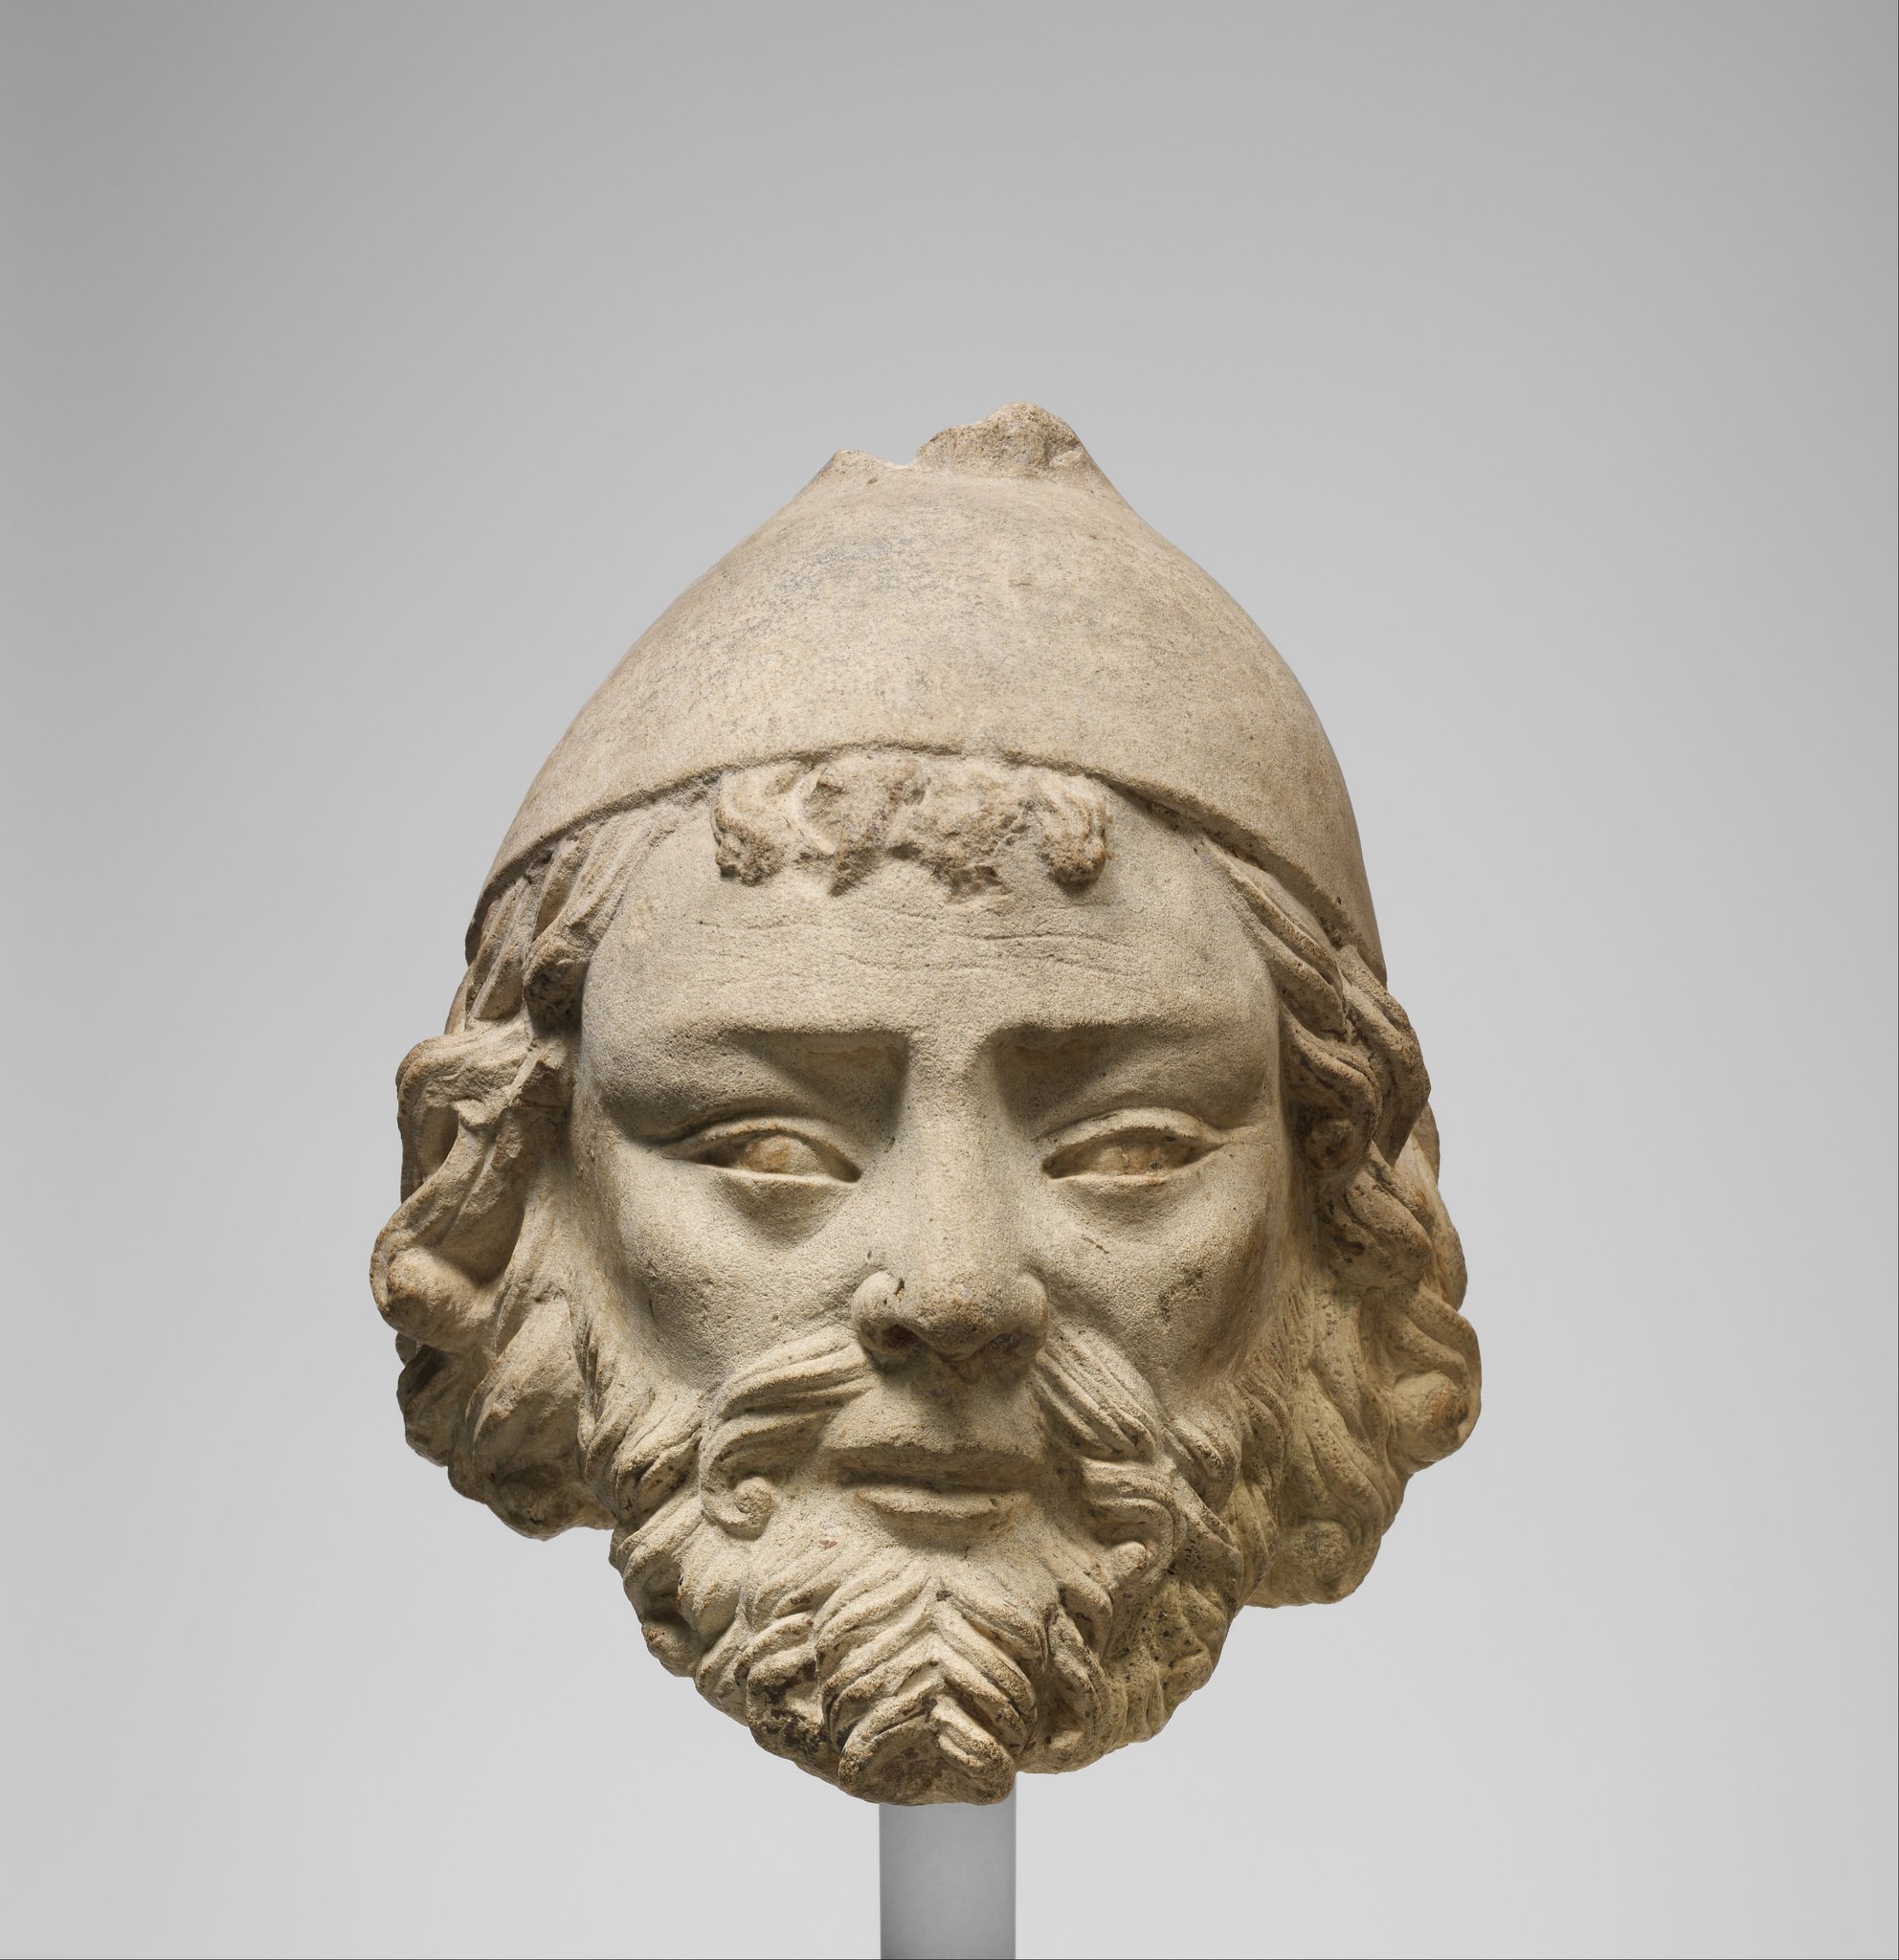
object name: statue head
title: Limestone Head of Joseph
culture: french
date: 1230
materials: limestone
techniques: polychromy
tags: heads,men,joseph